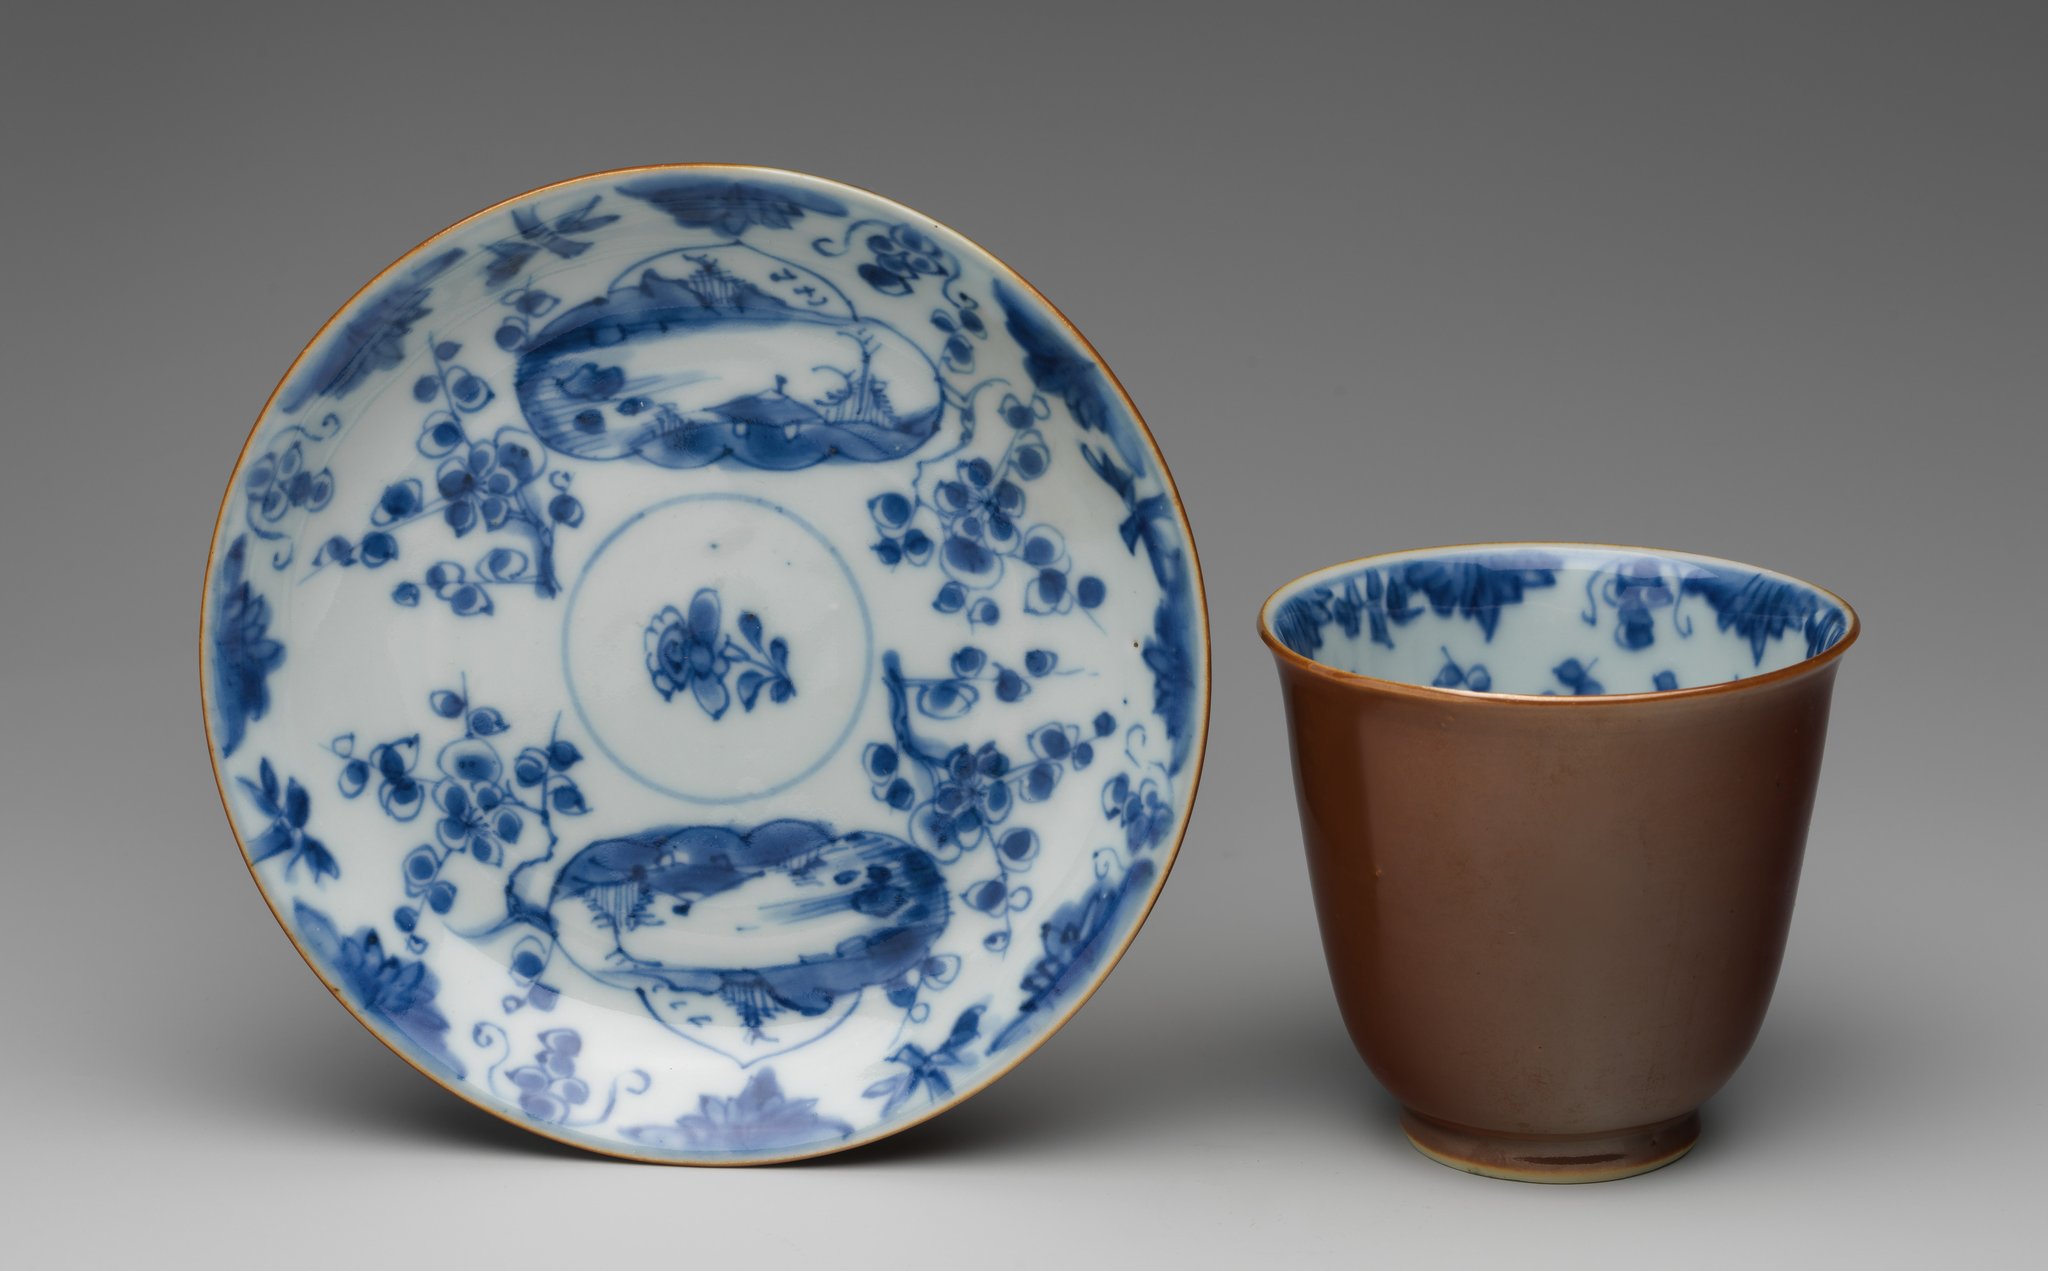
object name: beaker and saucer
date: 1700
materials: hard paste porcelain